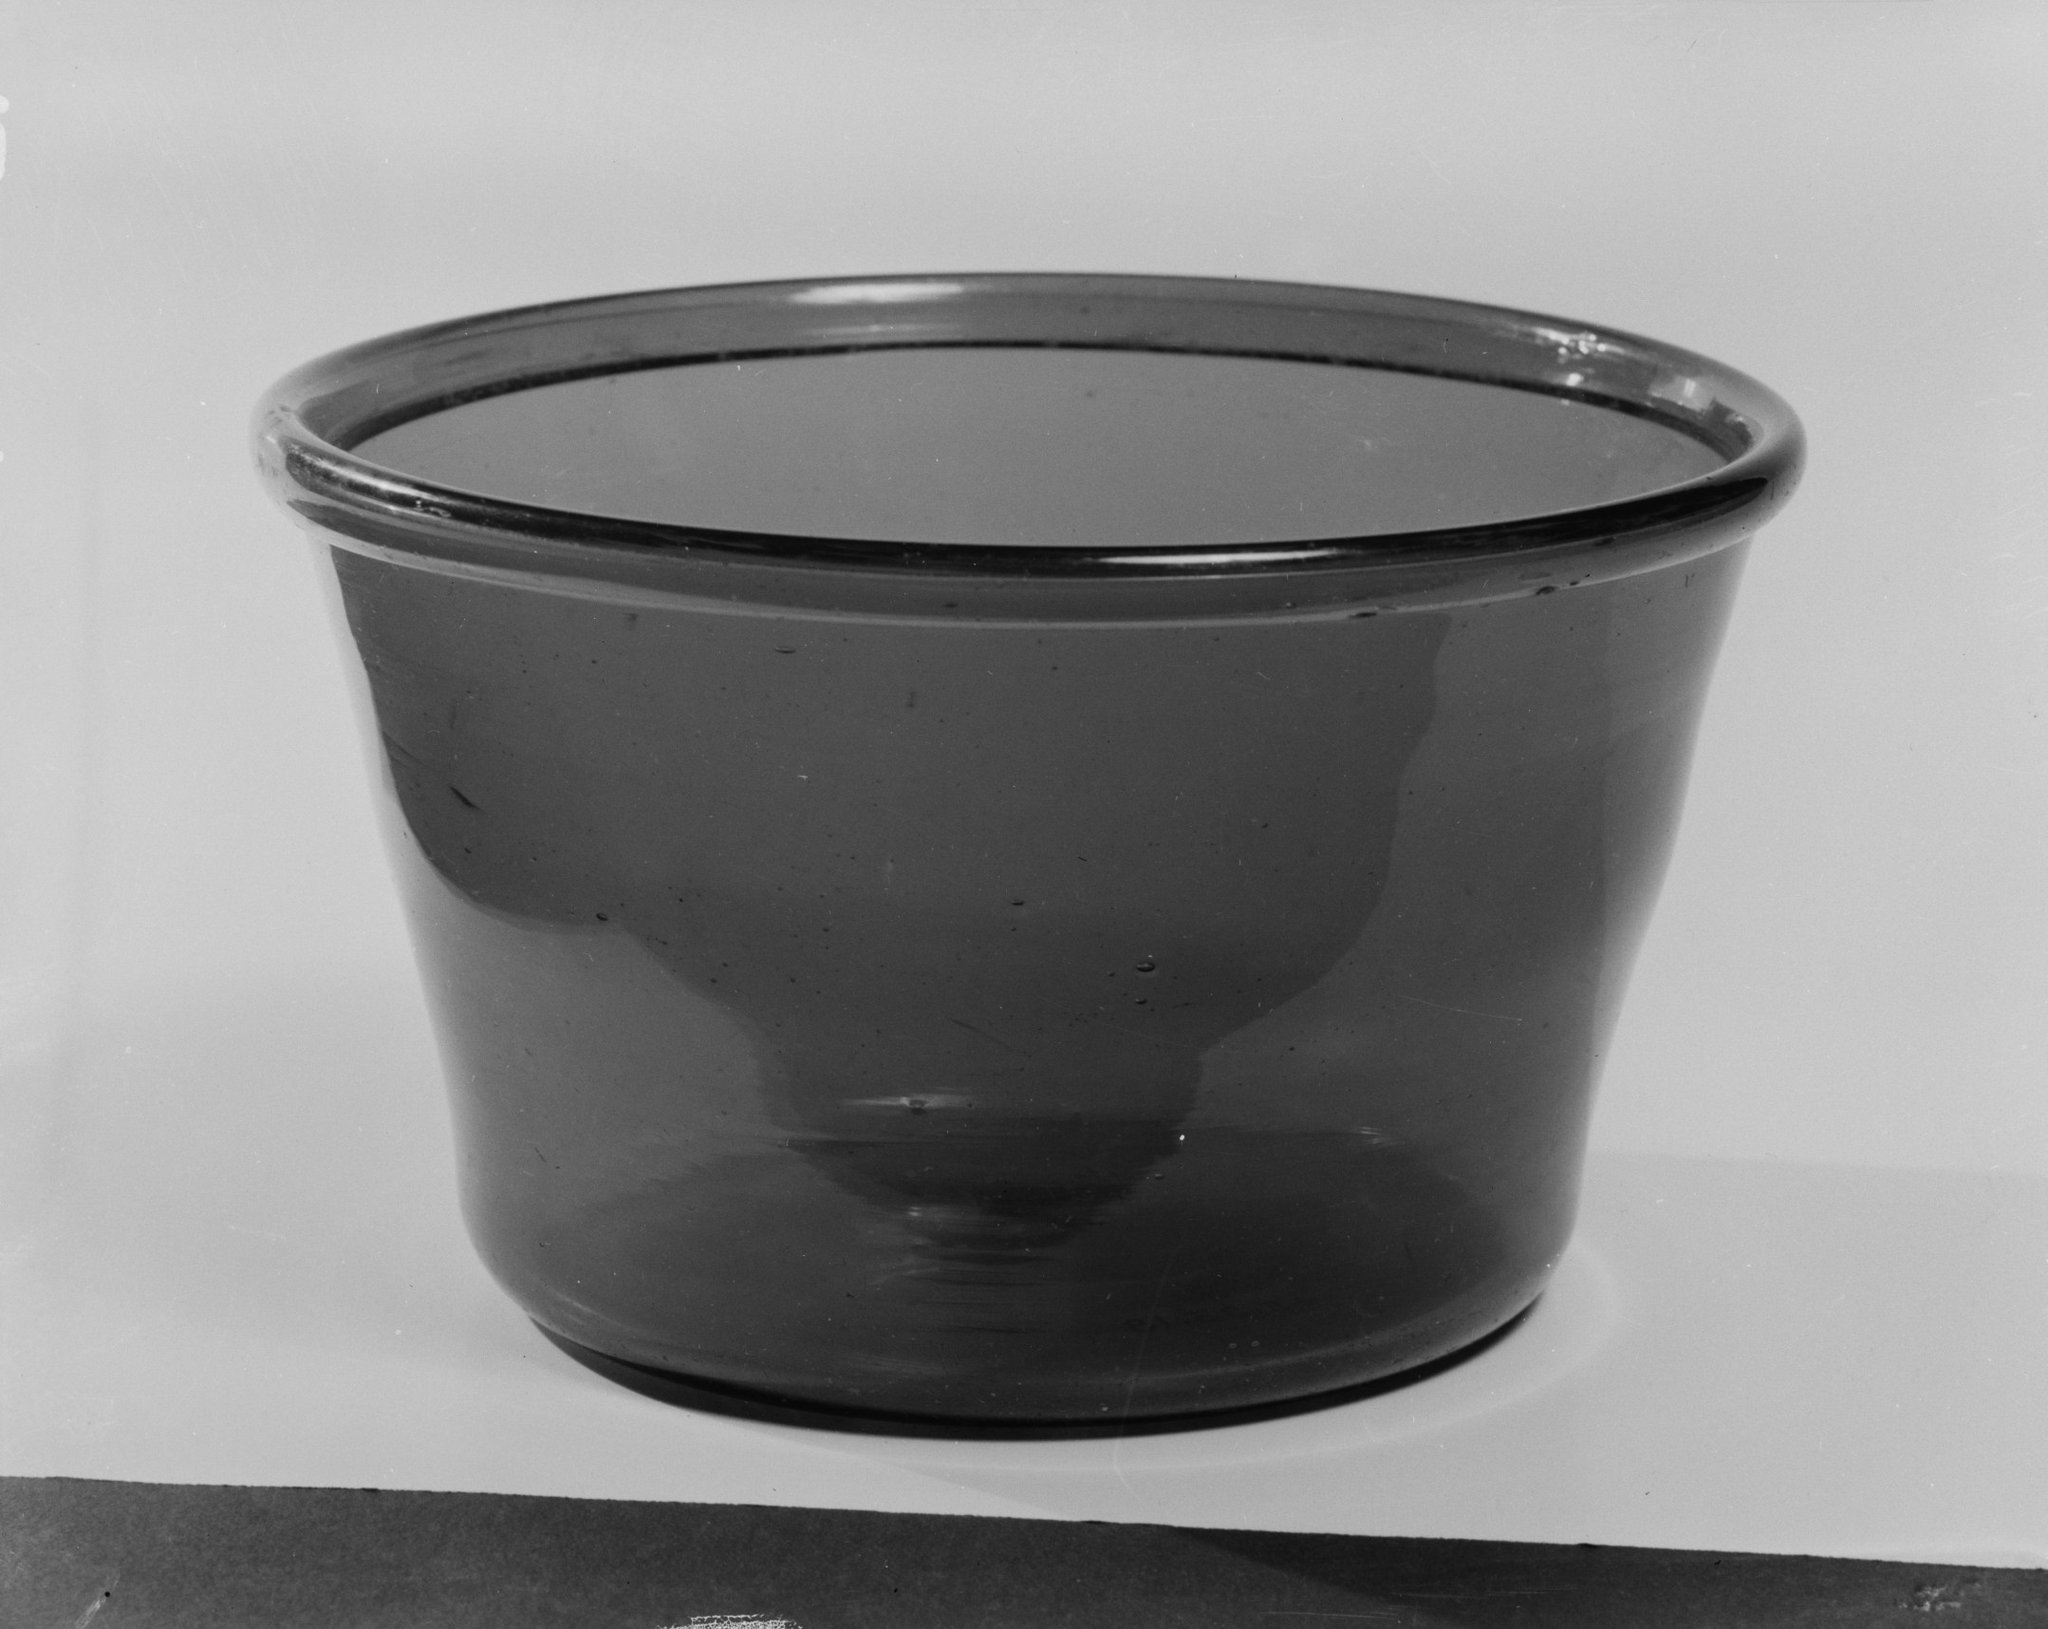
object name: bowl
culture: american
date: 1830-1870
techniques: glassblowing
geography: united states